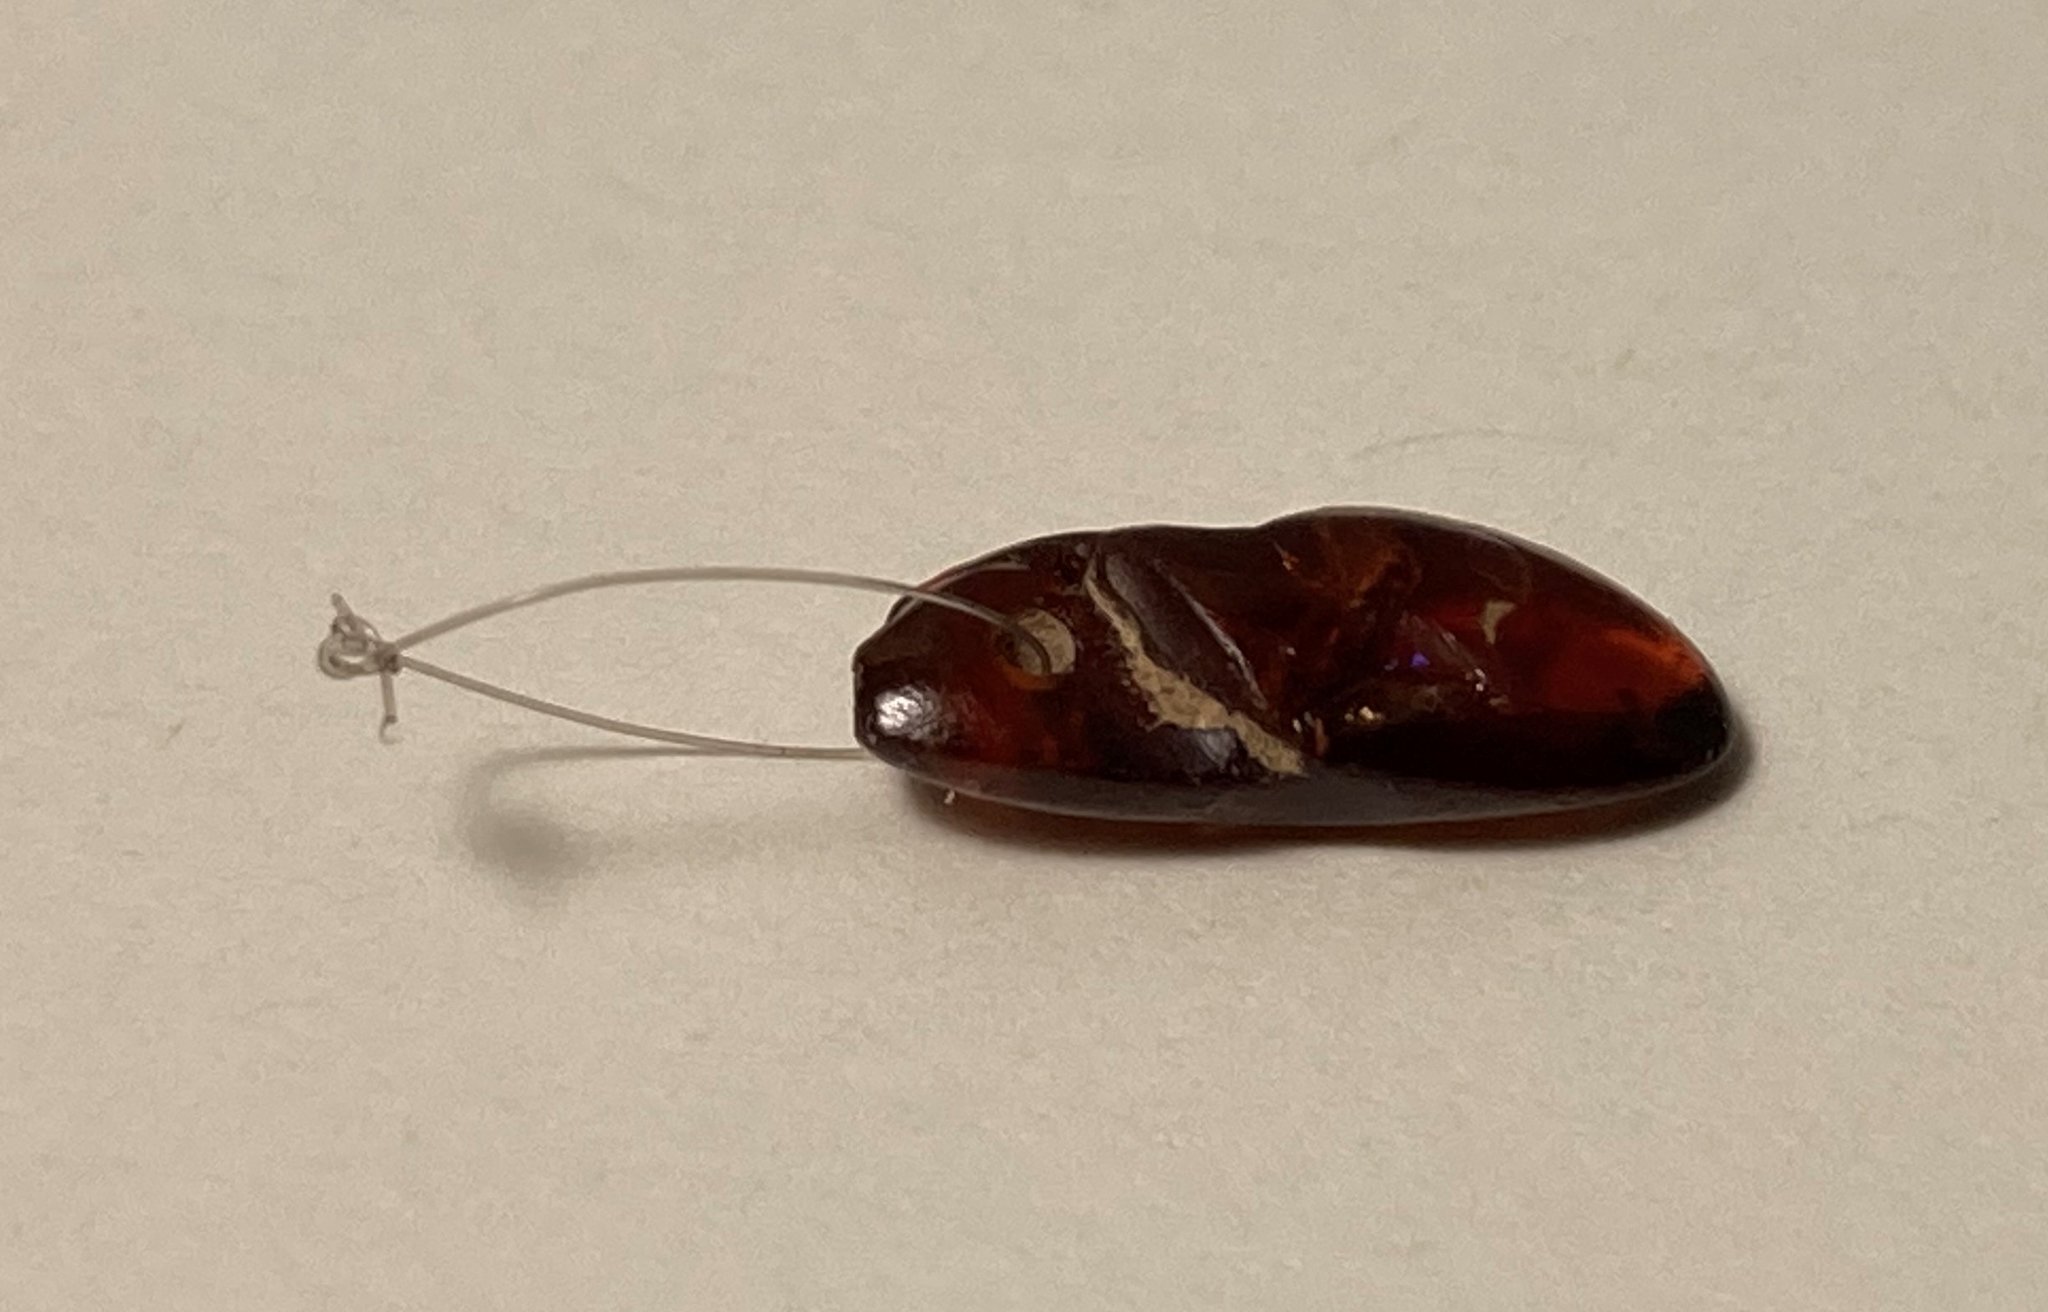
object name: stone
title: Drilled Stone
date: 701-1300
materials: gemstone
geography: iran